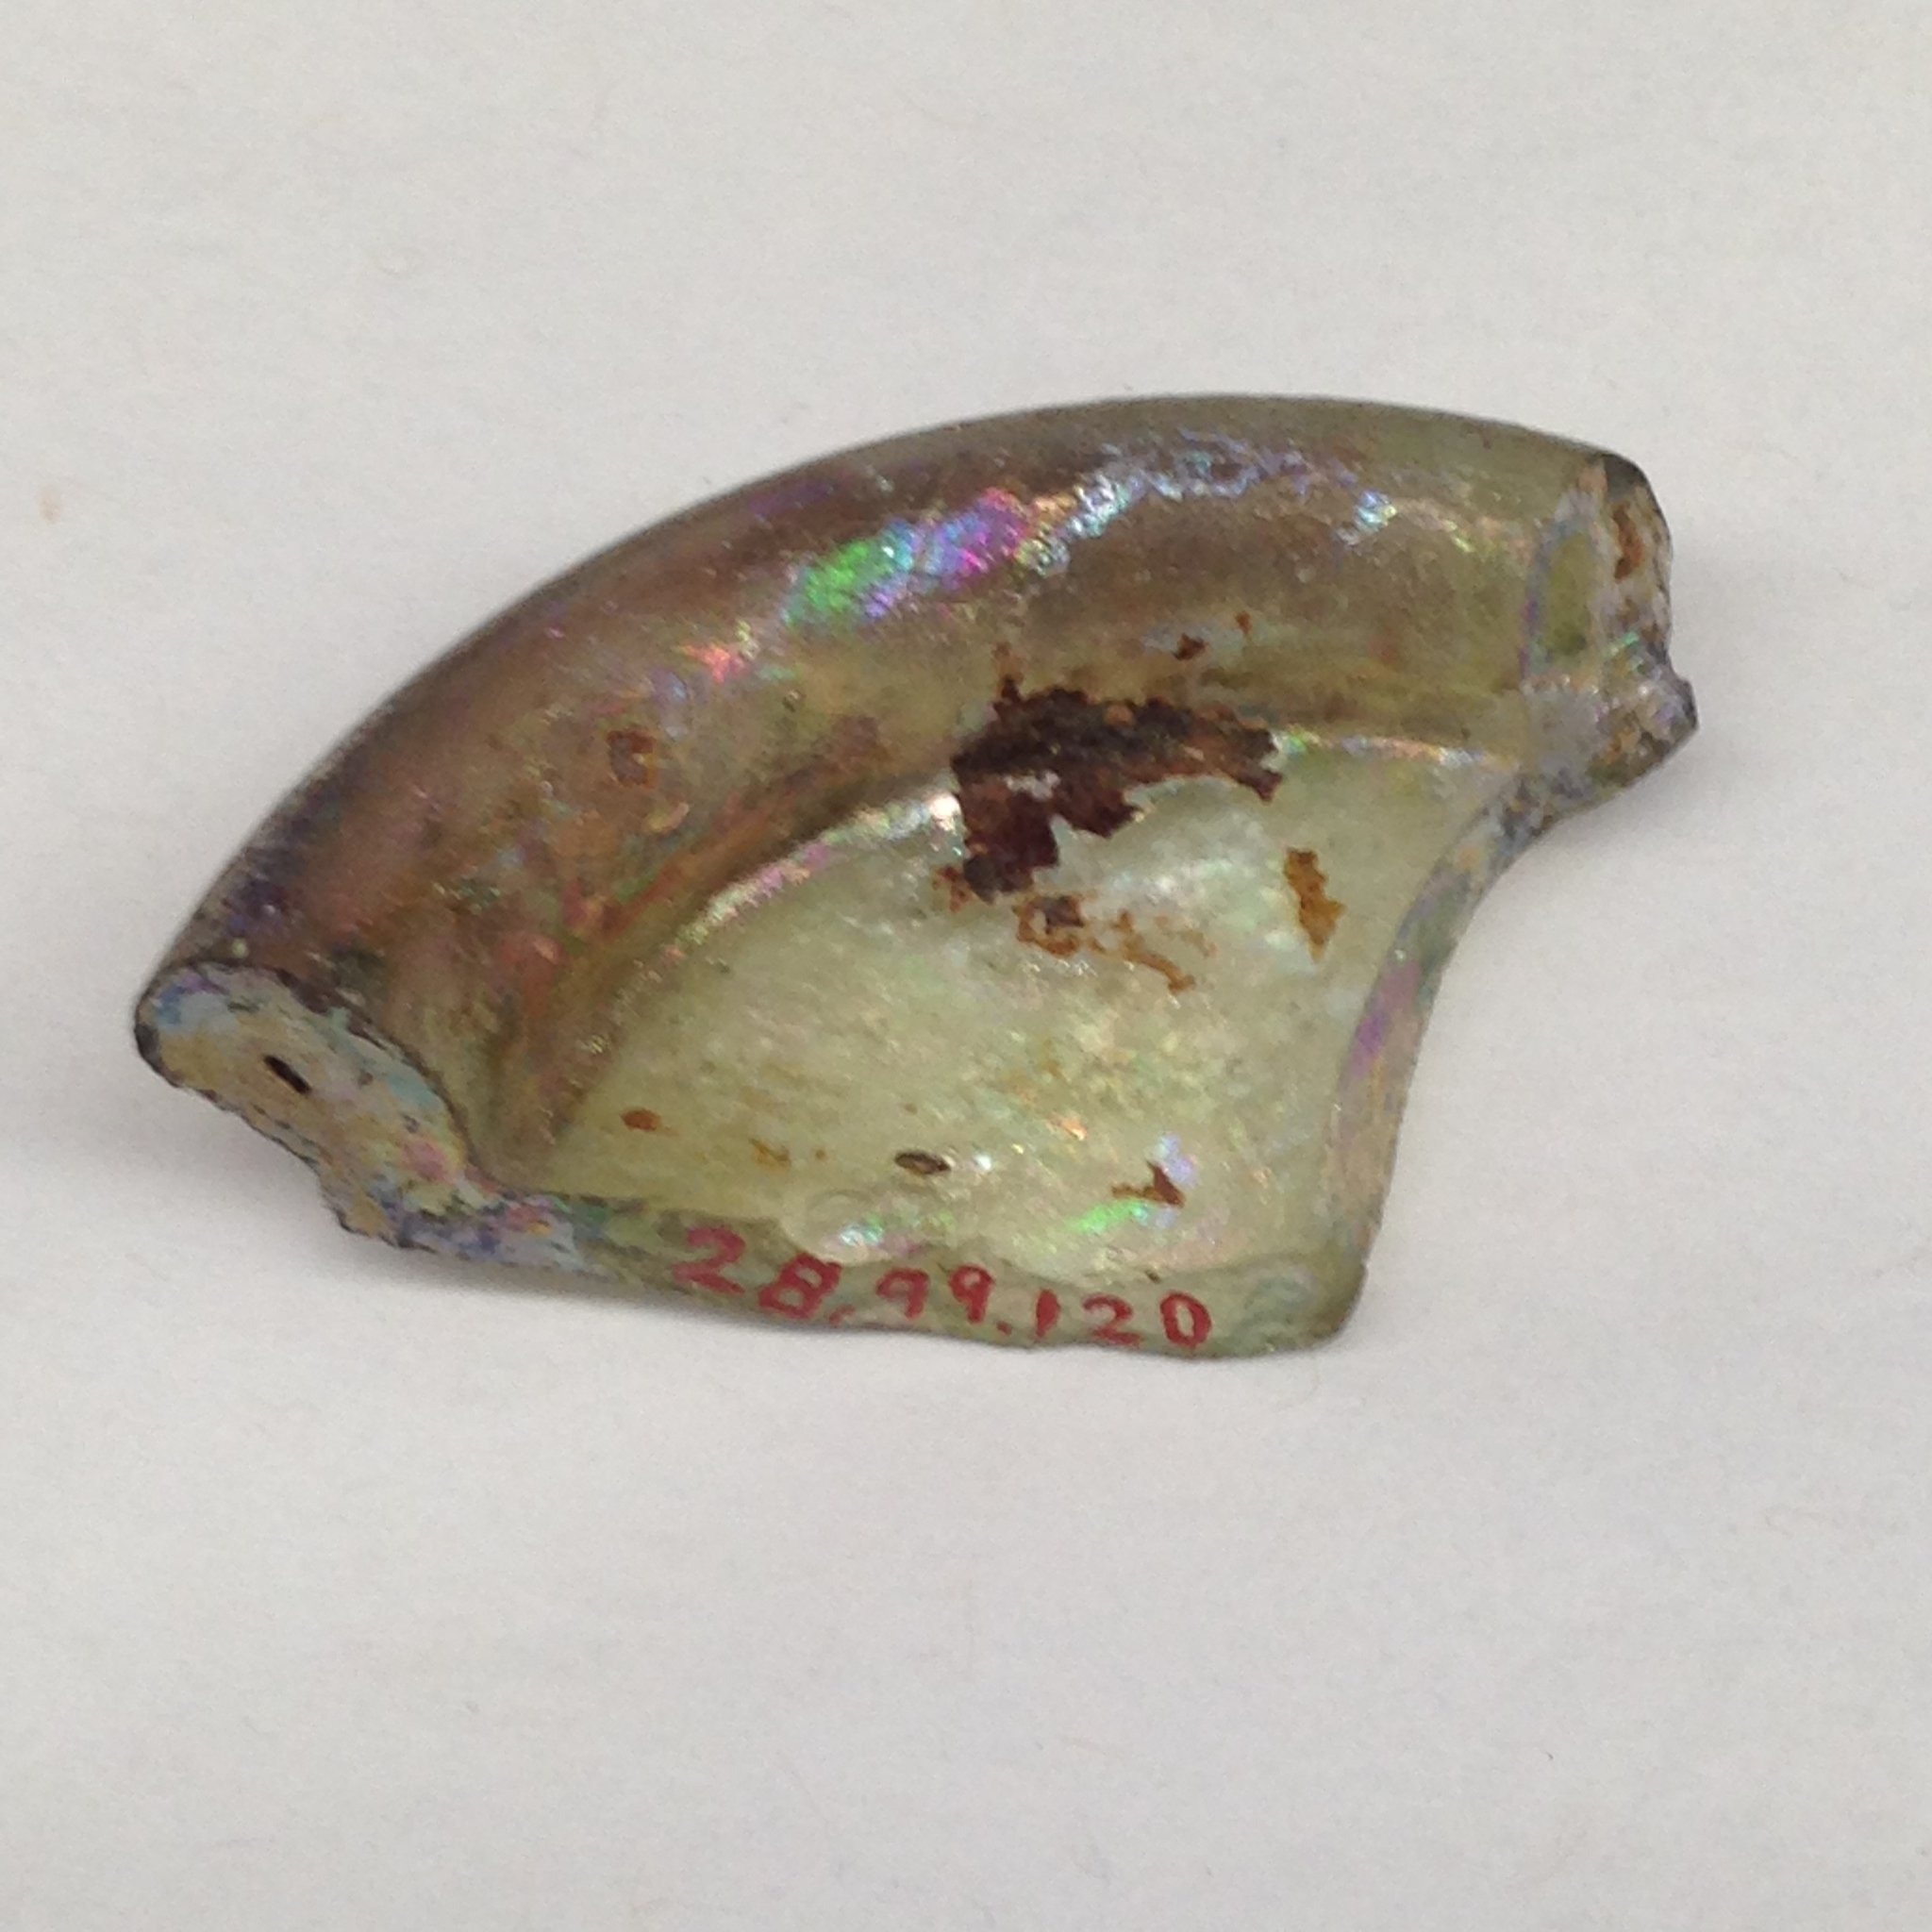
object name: fragment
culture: european or middle eastern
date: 1150-1250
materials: ceramic, glass